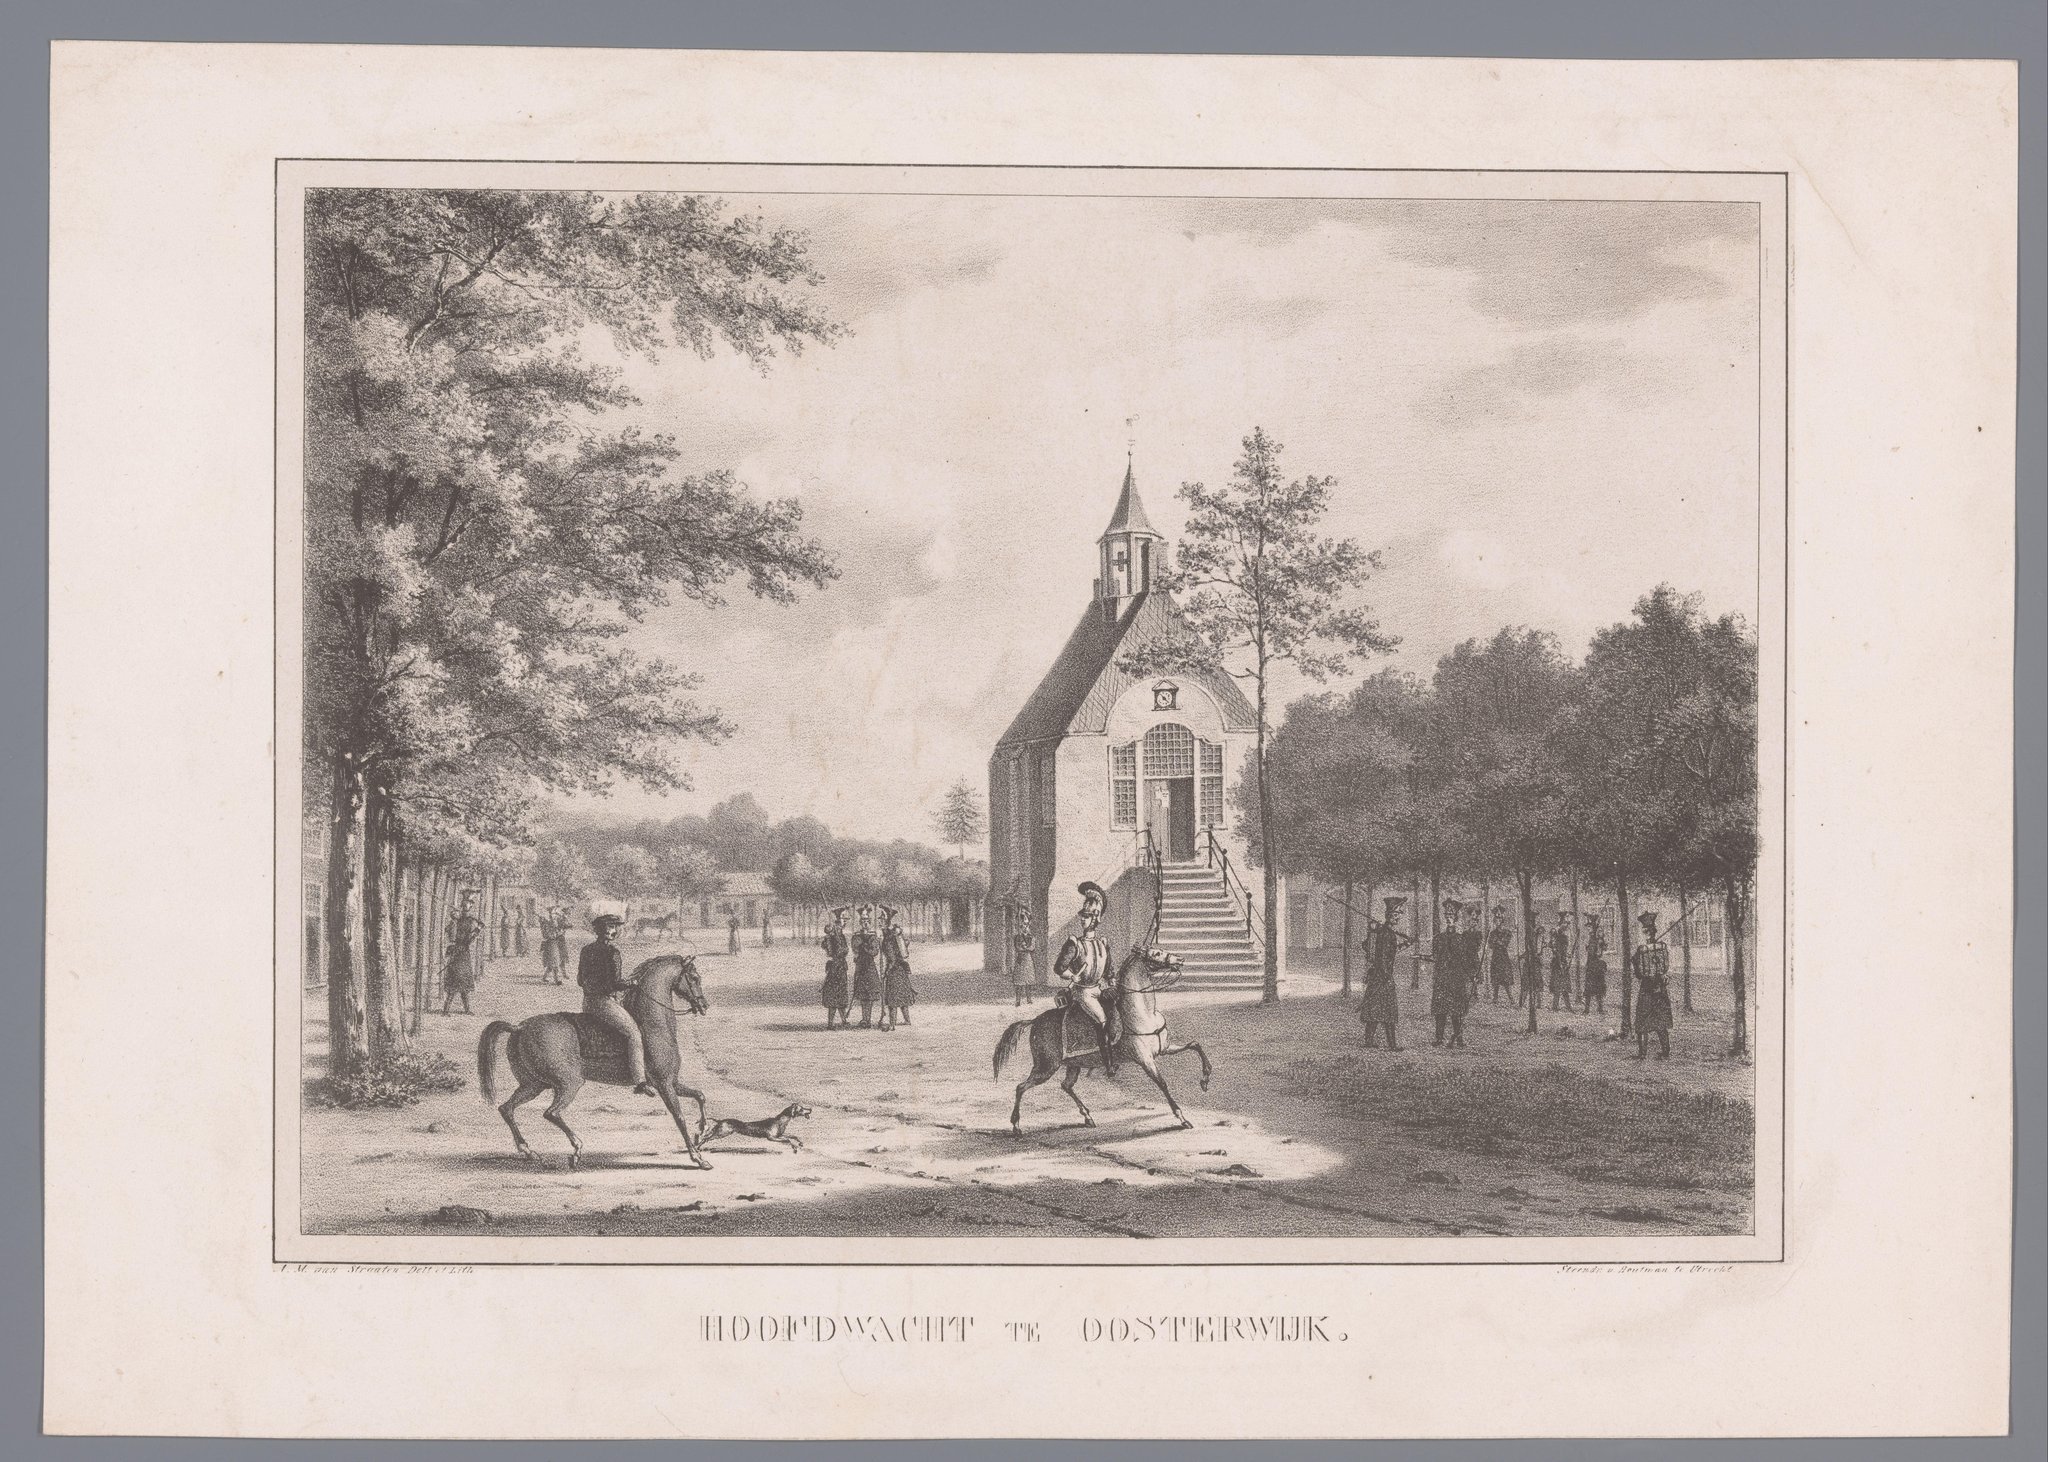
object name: print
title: Gezicht op de hoofdwacht in Oosterwijk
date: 1828-1843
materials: paper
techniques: lithograph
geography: utrecht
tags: barracks, oosterwijk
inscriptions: collector's mark: Lugt 2760, collector's mark: Lugt 2228